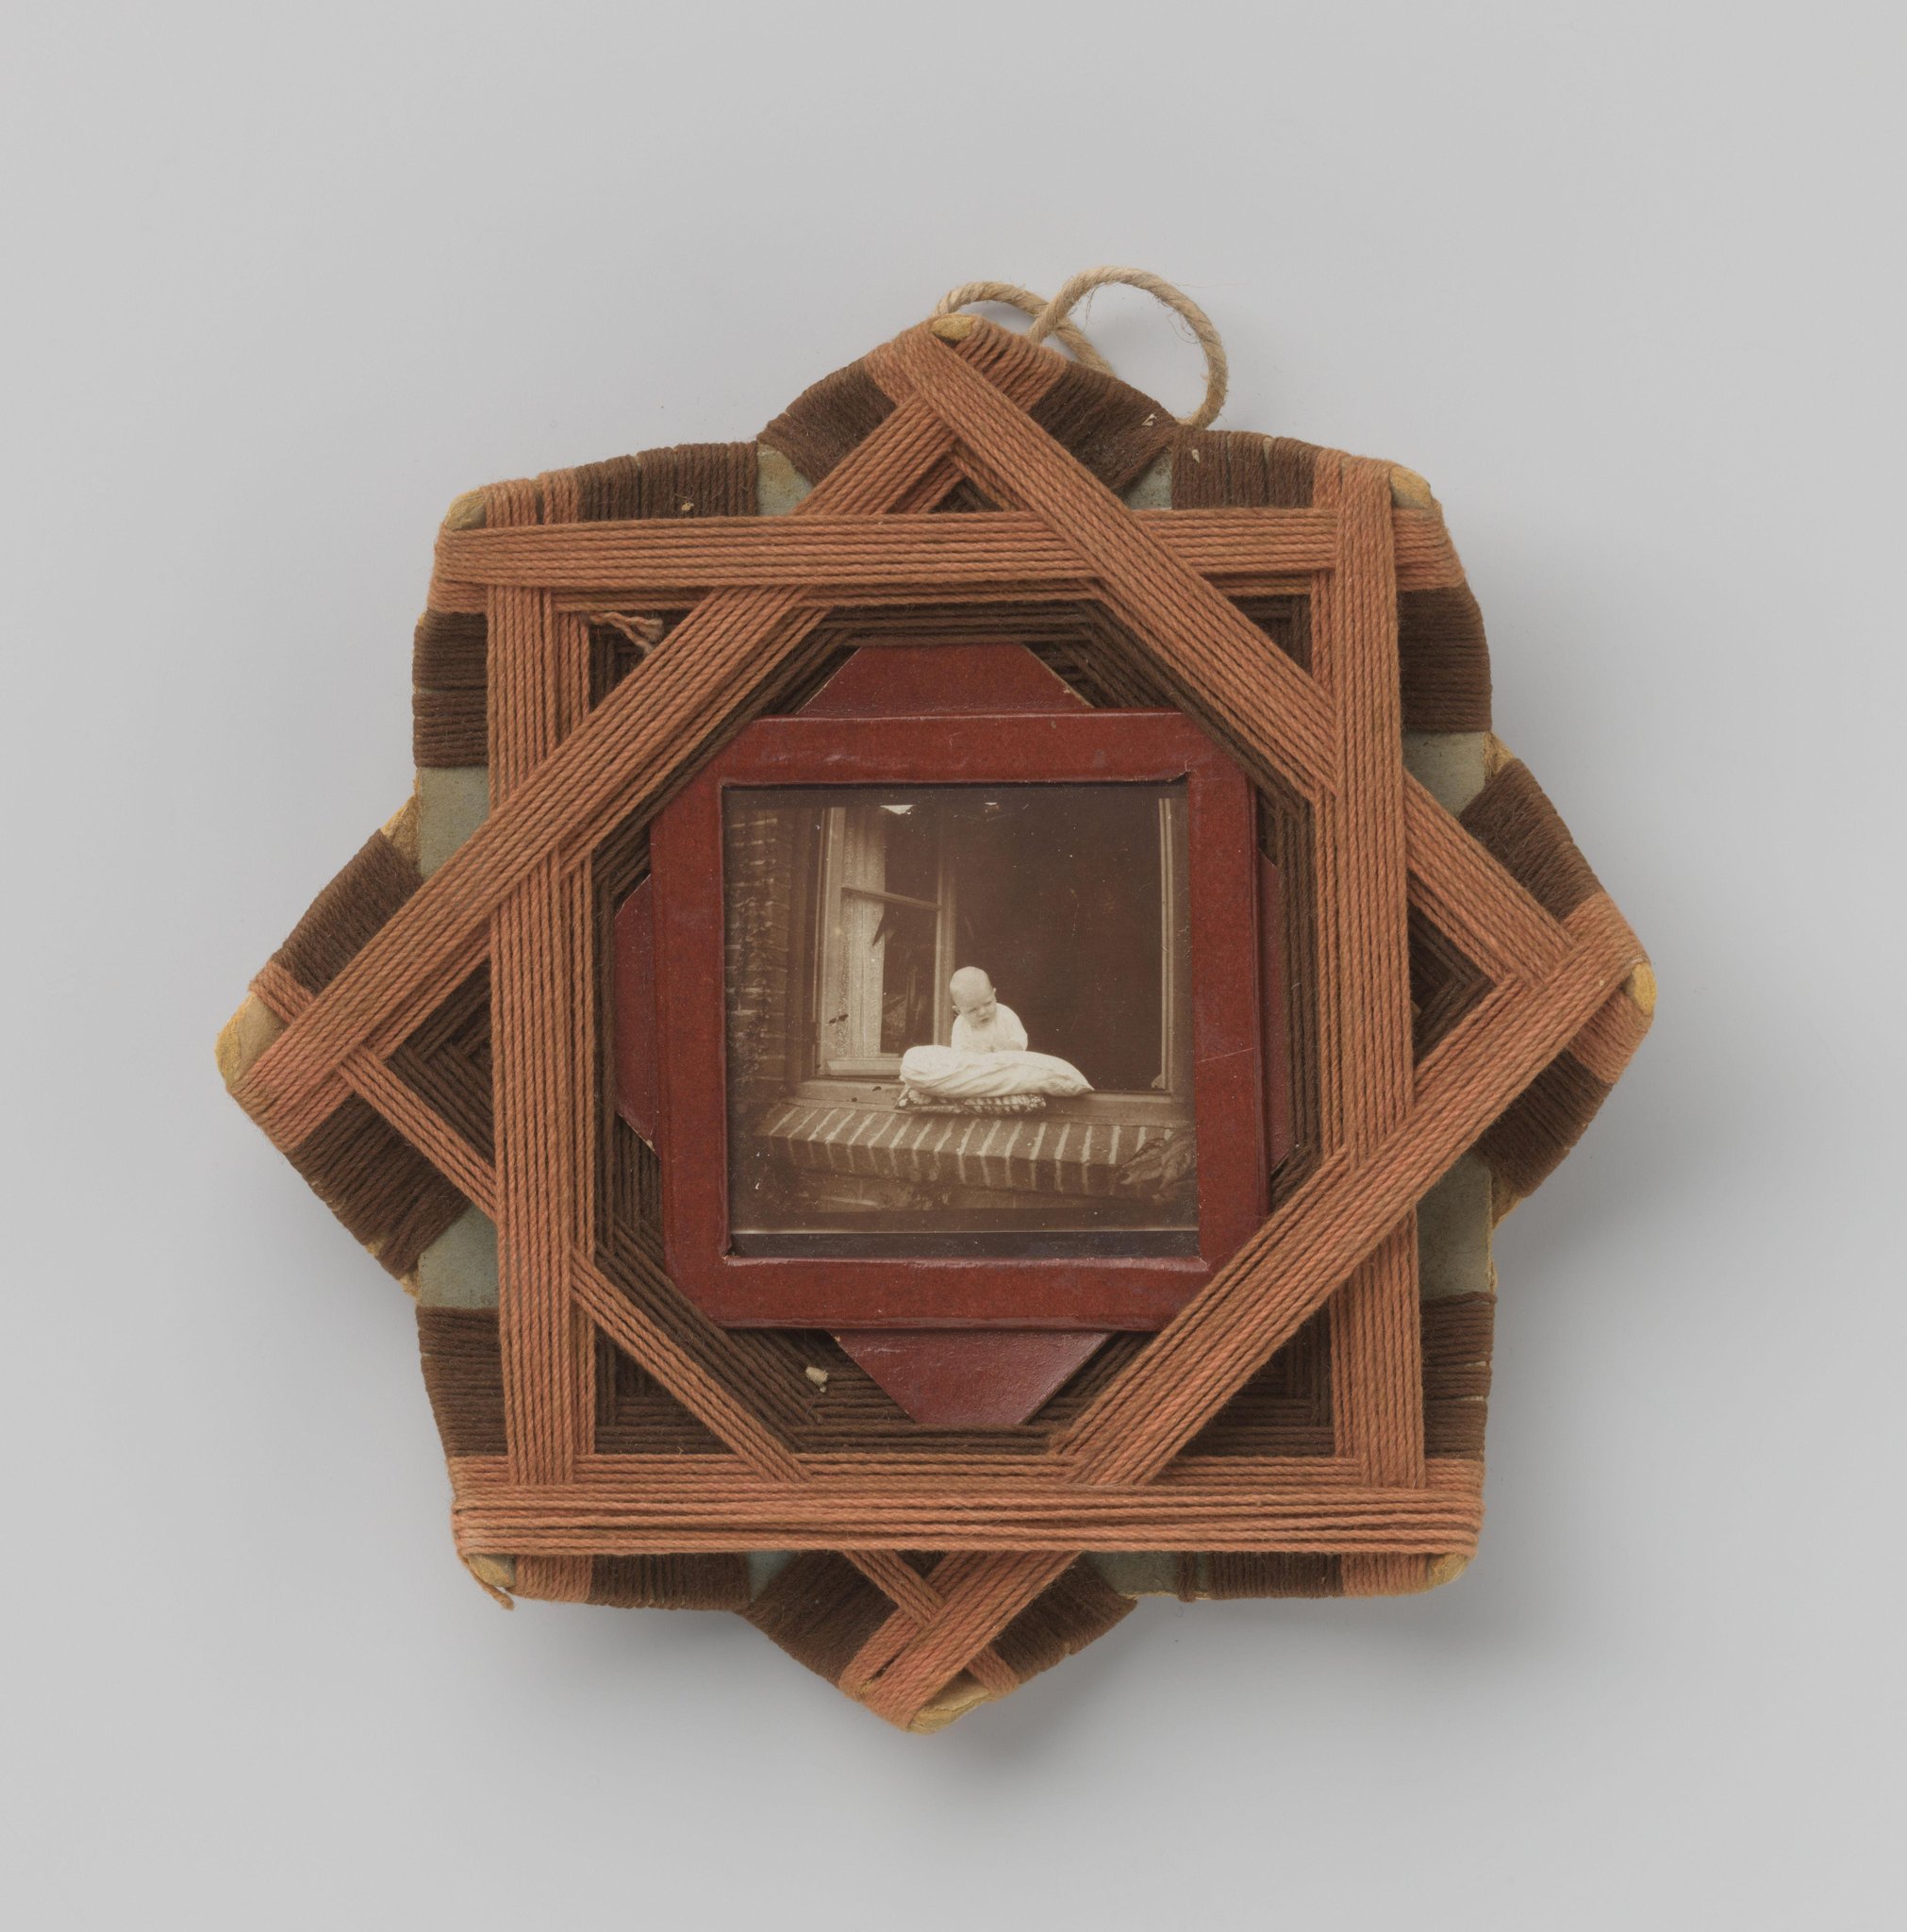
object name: frame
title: Portret van een onbekend kind bij een raam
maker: Anonymous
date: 1880-1900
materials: paper, cardboard, fiber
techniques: gelatin silver print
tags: child, anonymous historical person portrayed